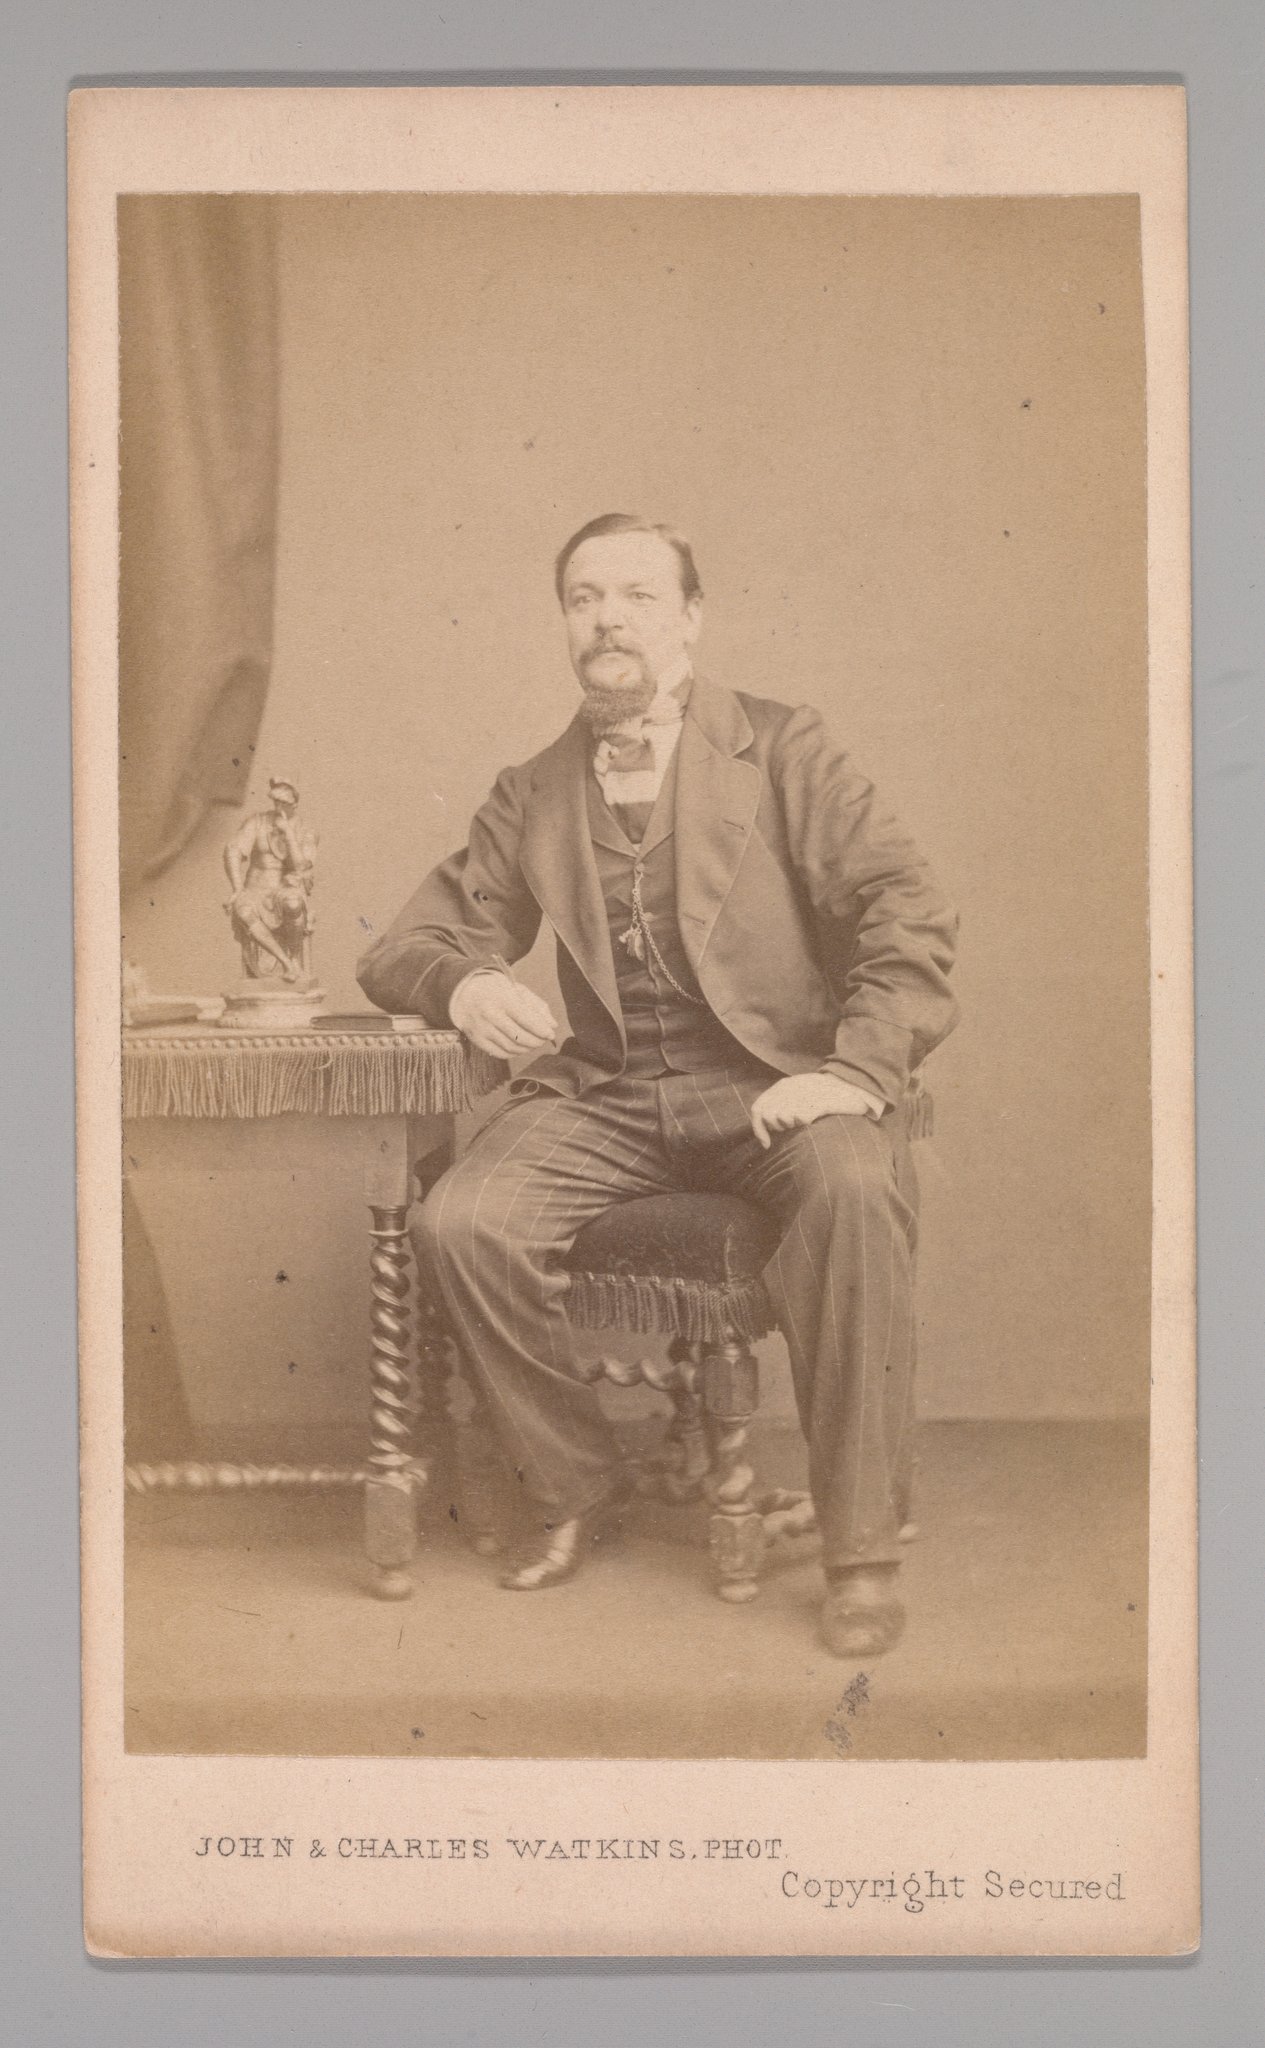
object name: carte de visite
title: [George Augustus Sala]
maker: john and charles watkins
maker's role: photography studio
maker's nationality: british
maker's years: 1840-1875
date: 1860-1869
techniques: albumen silver print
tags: men,portraits